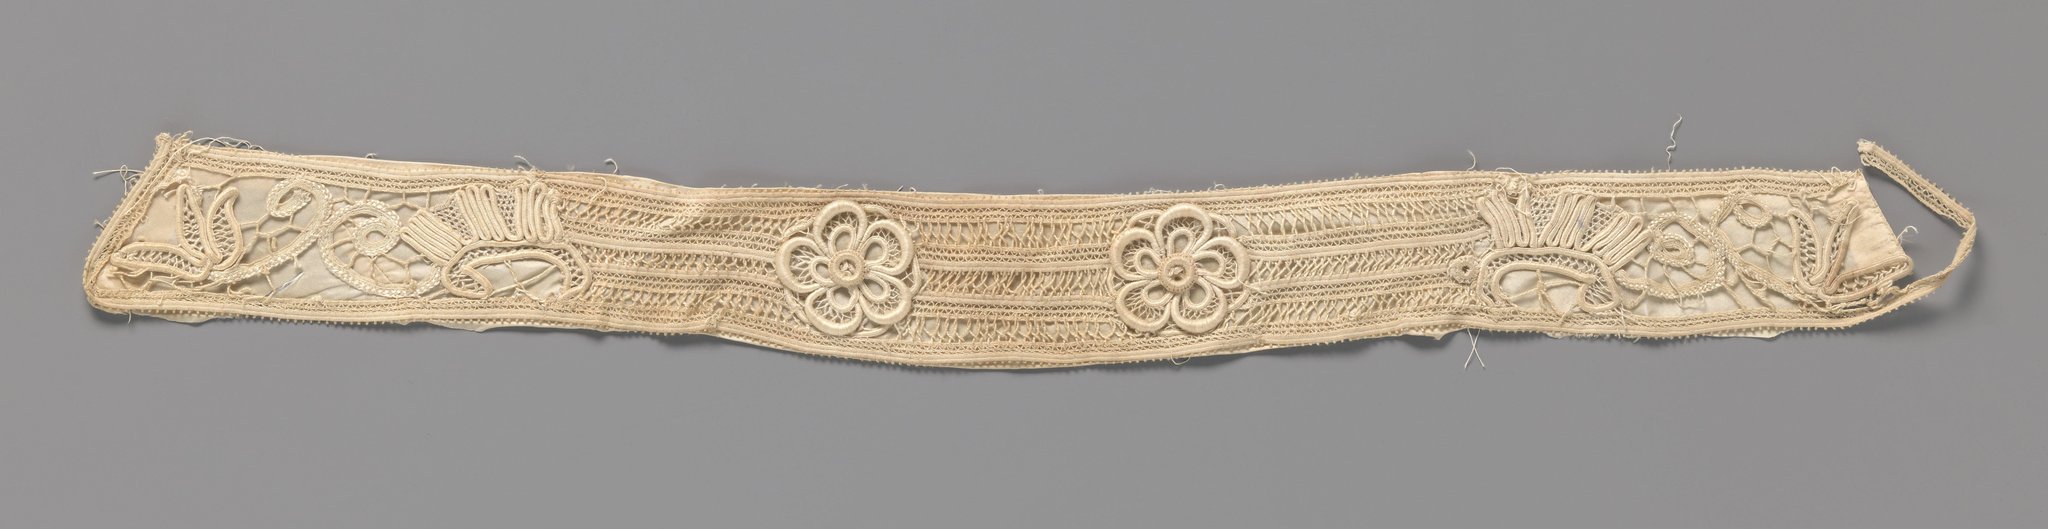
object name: braid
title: Passement van machinale kant met twee dikke reliëf rozetten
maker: Anonymous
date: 1900-1910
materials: silk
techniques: lace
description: Passement van naturelkleurige machinale kant met twee dikke reliëf rozetten. De strook is gevoerd met crèmekleurig satijn.